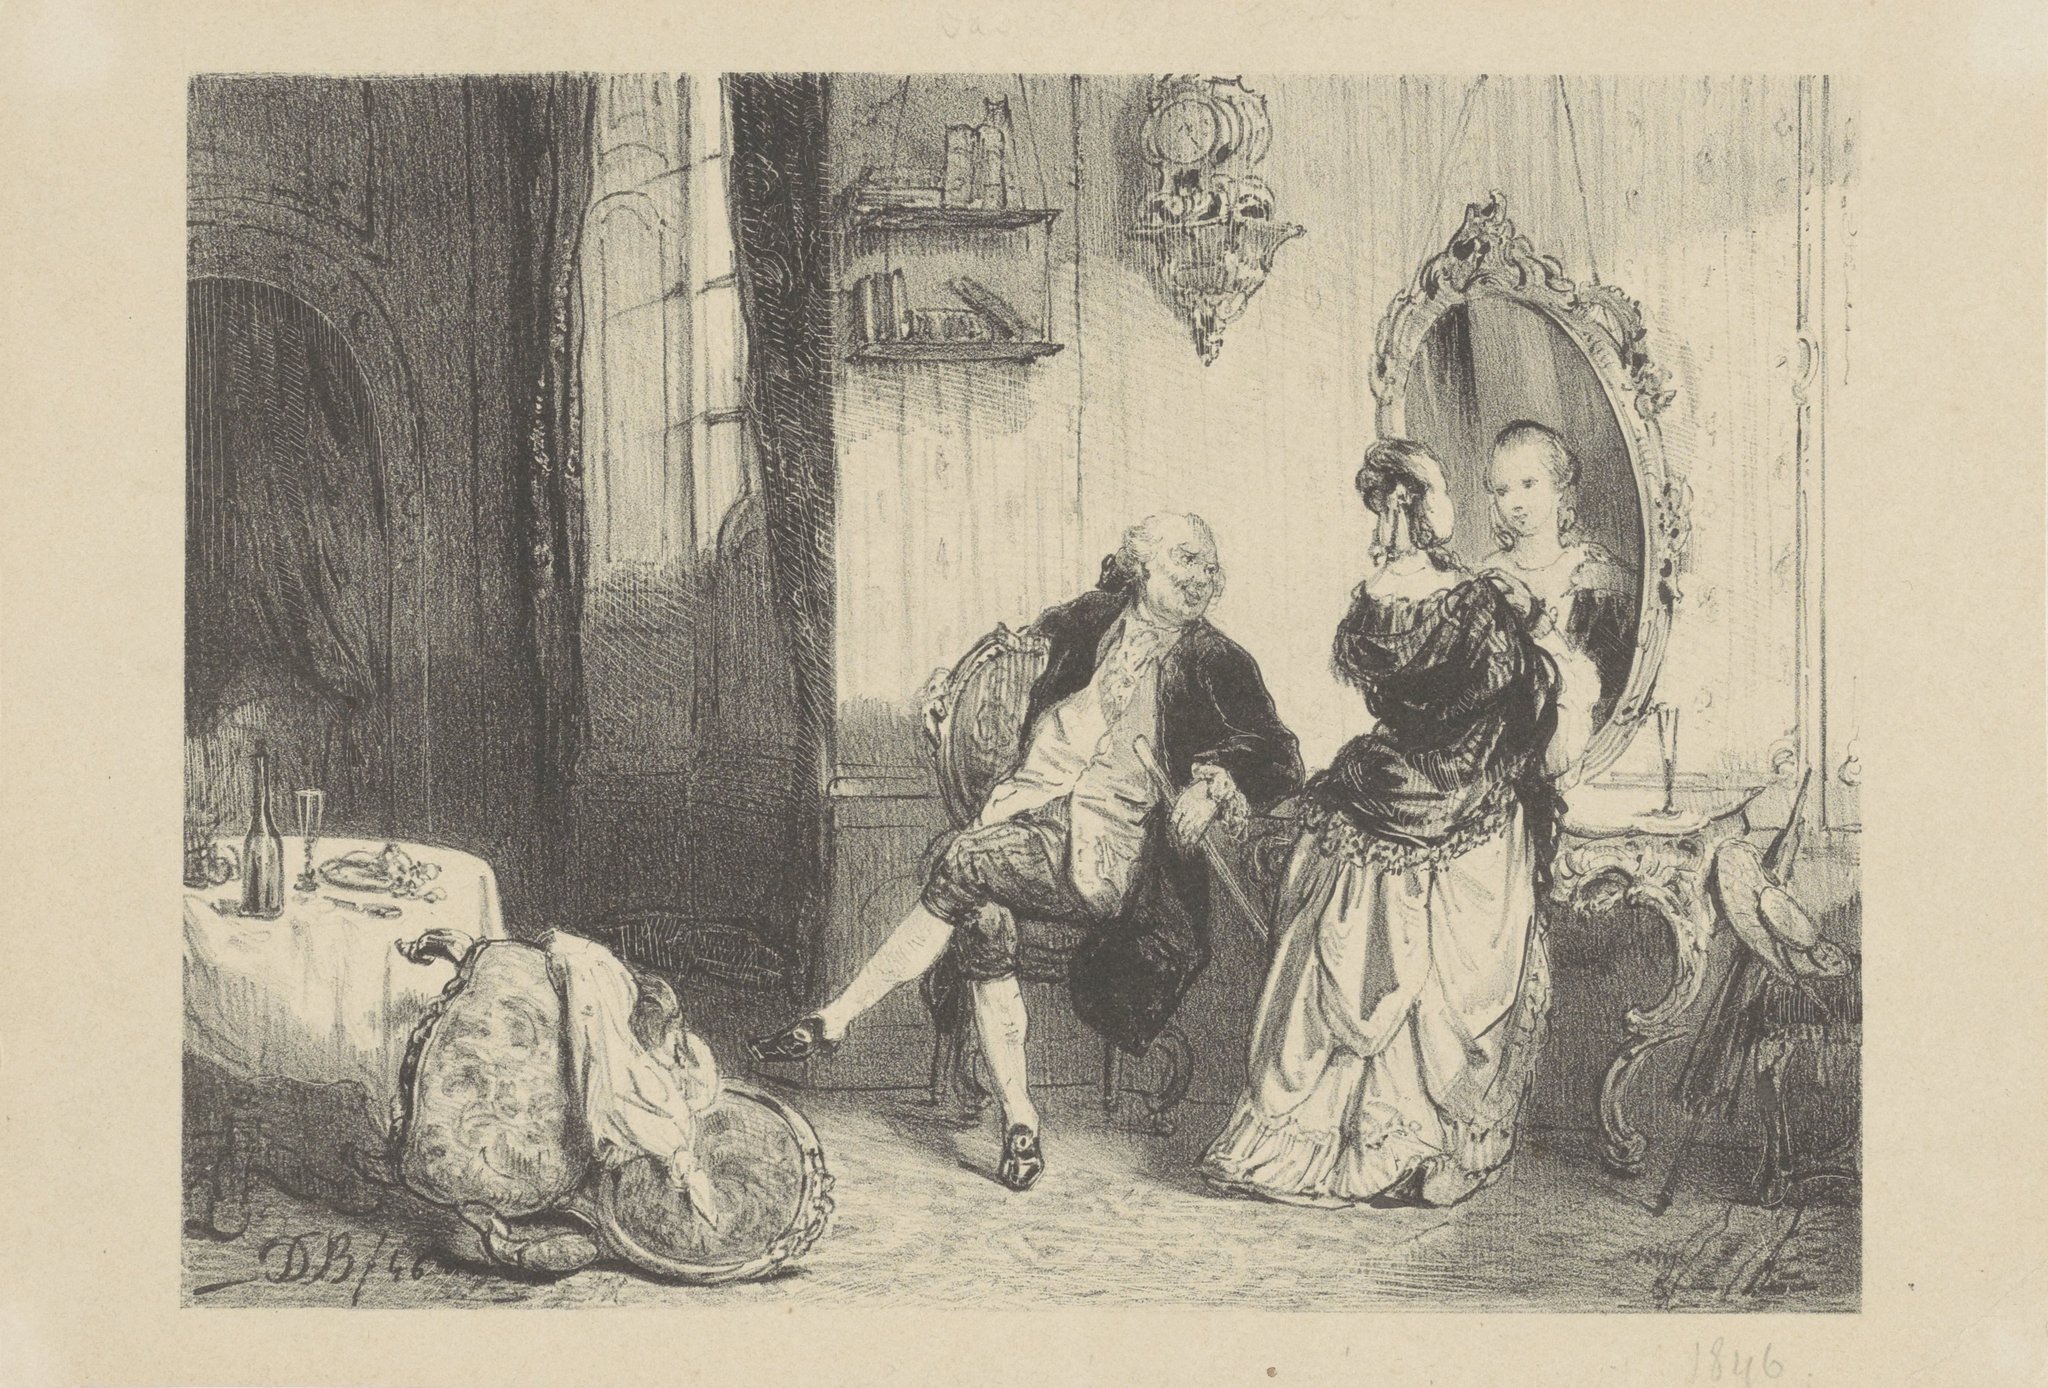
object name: print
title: Man en vrouw in achttiende-eeuws interieur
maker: david bles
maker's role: draughtsman, painter, print maker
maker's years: 1821-1899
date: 1846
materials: paper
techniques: lithograph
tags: mirror, chair, dining-room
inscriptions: collector's mark: Lugt 2228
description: De vrouw staat voor de spiegel, de man zit naast haar op een stoel. Links staat een gedekte tafel met daarbij een omgevallen stoel.